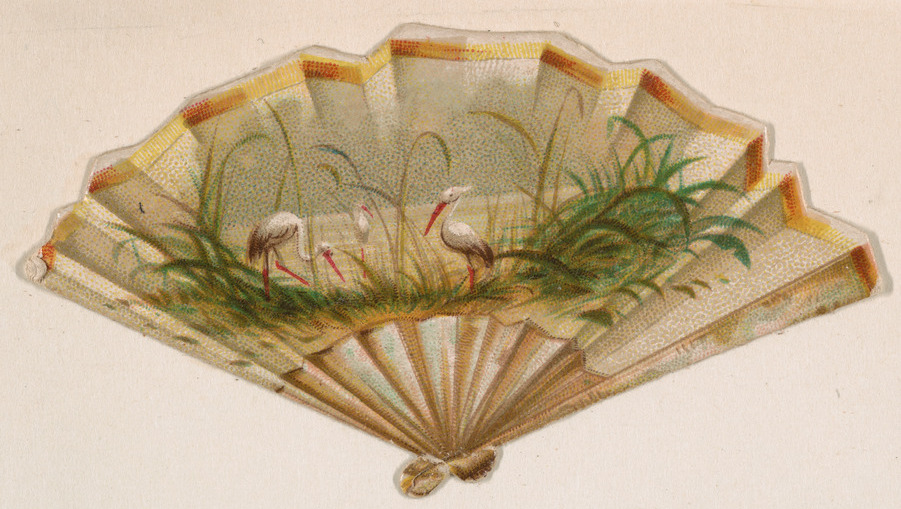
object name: print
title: Fan, from the Novelties series (N228, Type 4) issued by Kinney Bros.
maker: kinney brothers tobacco company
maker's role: publisher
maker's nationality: american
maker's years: 1869-2011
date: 1889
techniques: color lithograph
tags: fans,swans